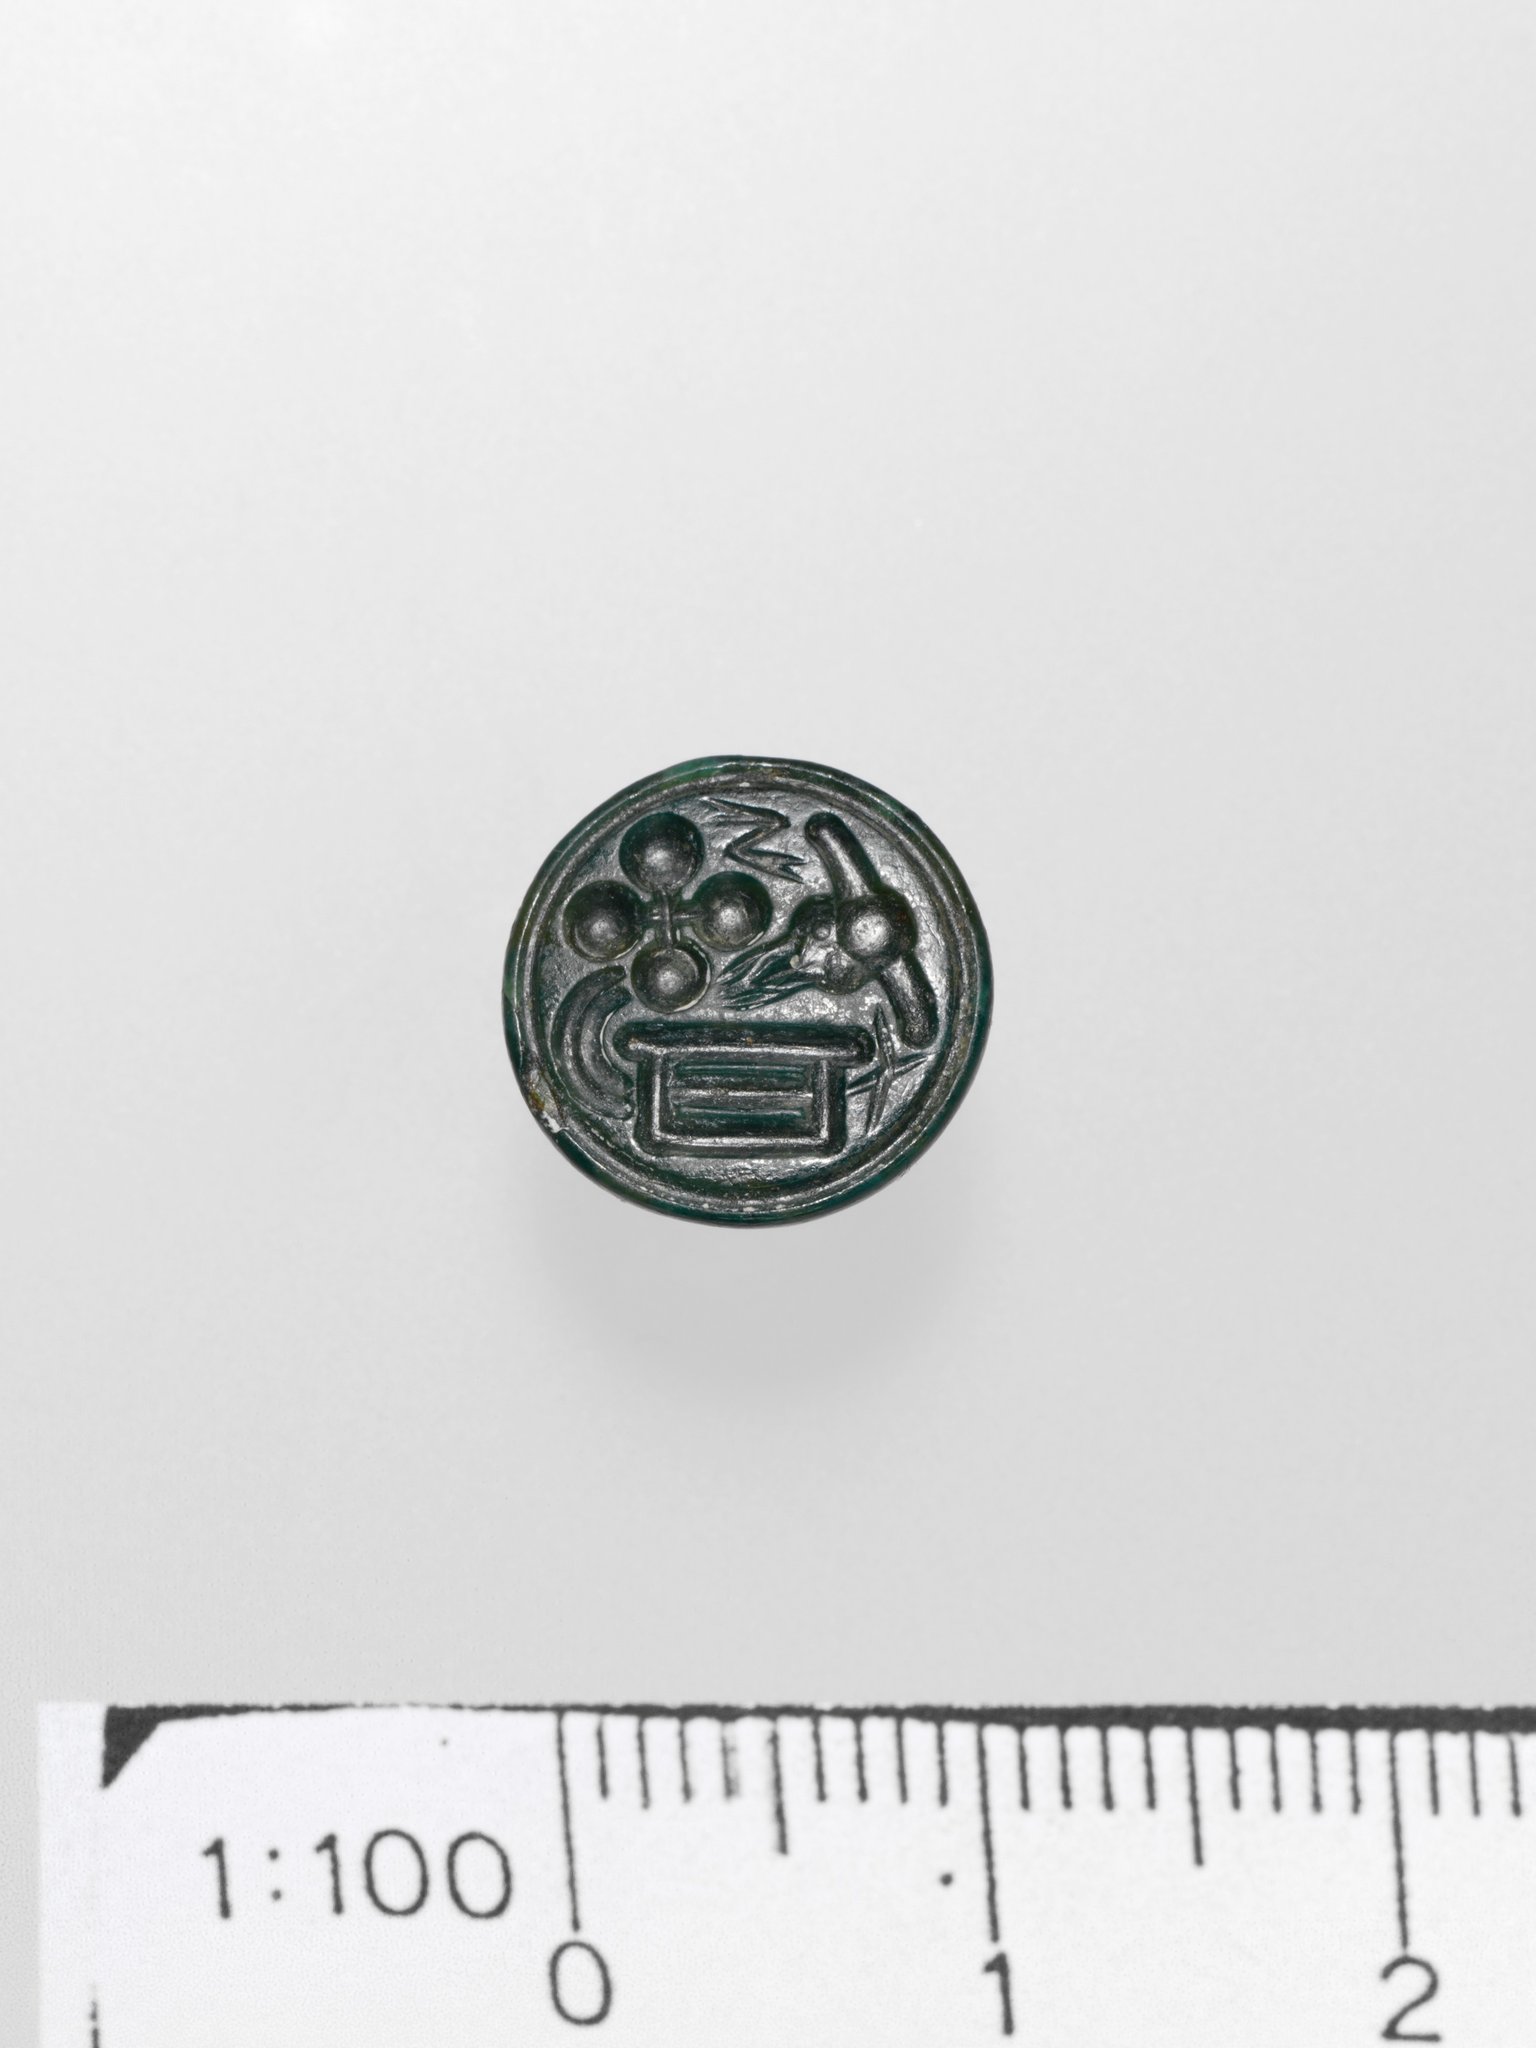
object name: seal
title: Jasper stamp seal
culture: minoan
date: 1750-1600 BCE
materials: glass